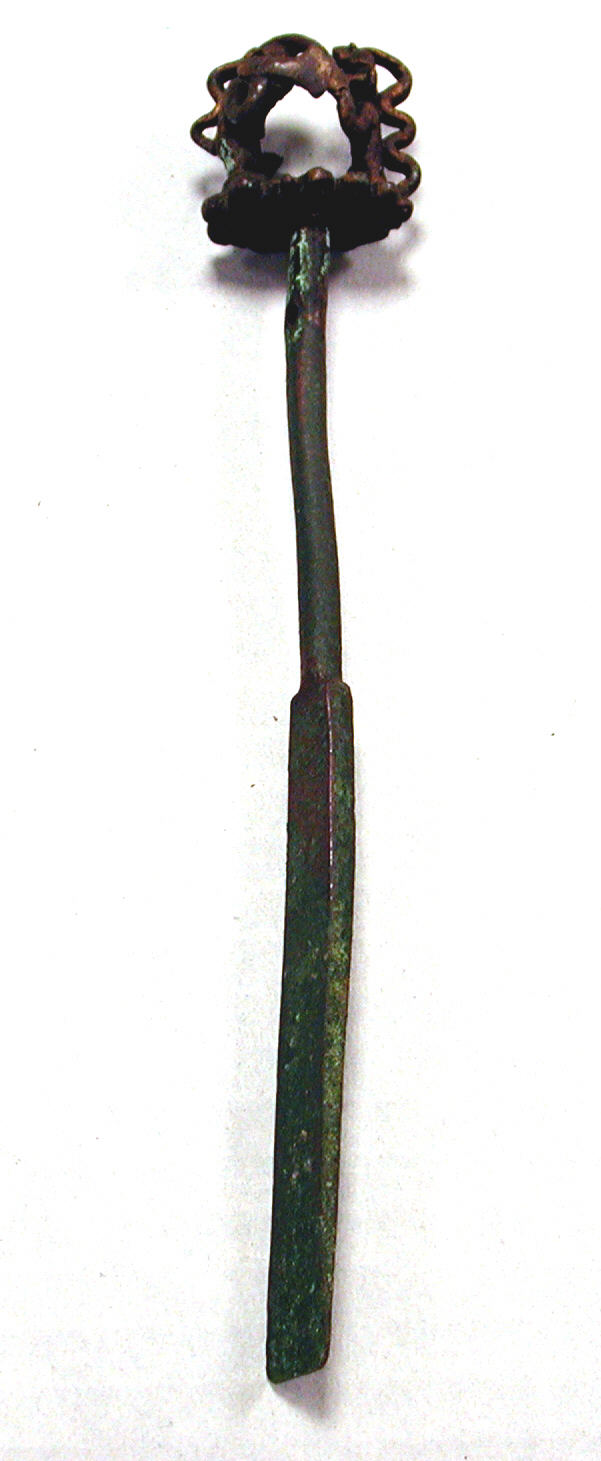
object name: knife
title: Ceremonial Knife (Tumi)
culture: moche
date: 101-700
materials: copper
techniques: casting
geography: peru